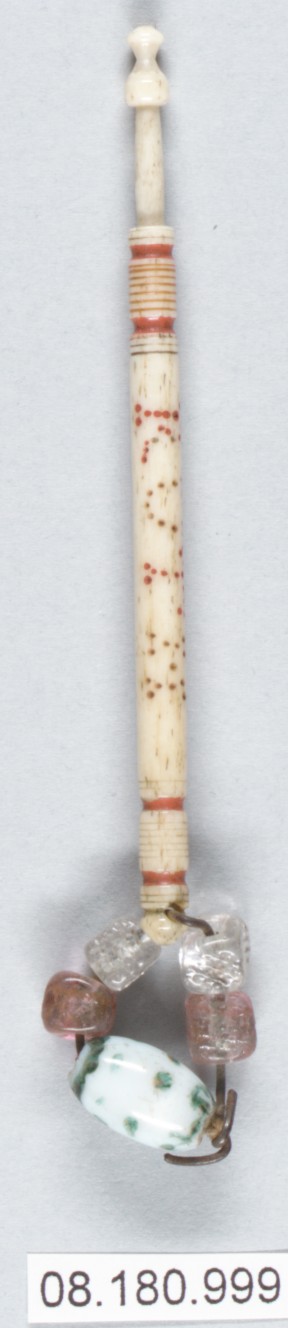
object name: bobbin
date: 1801-1900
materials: bone